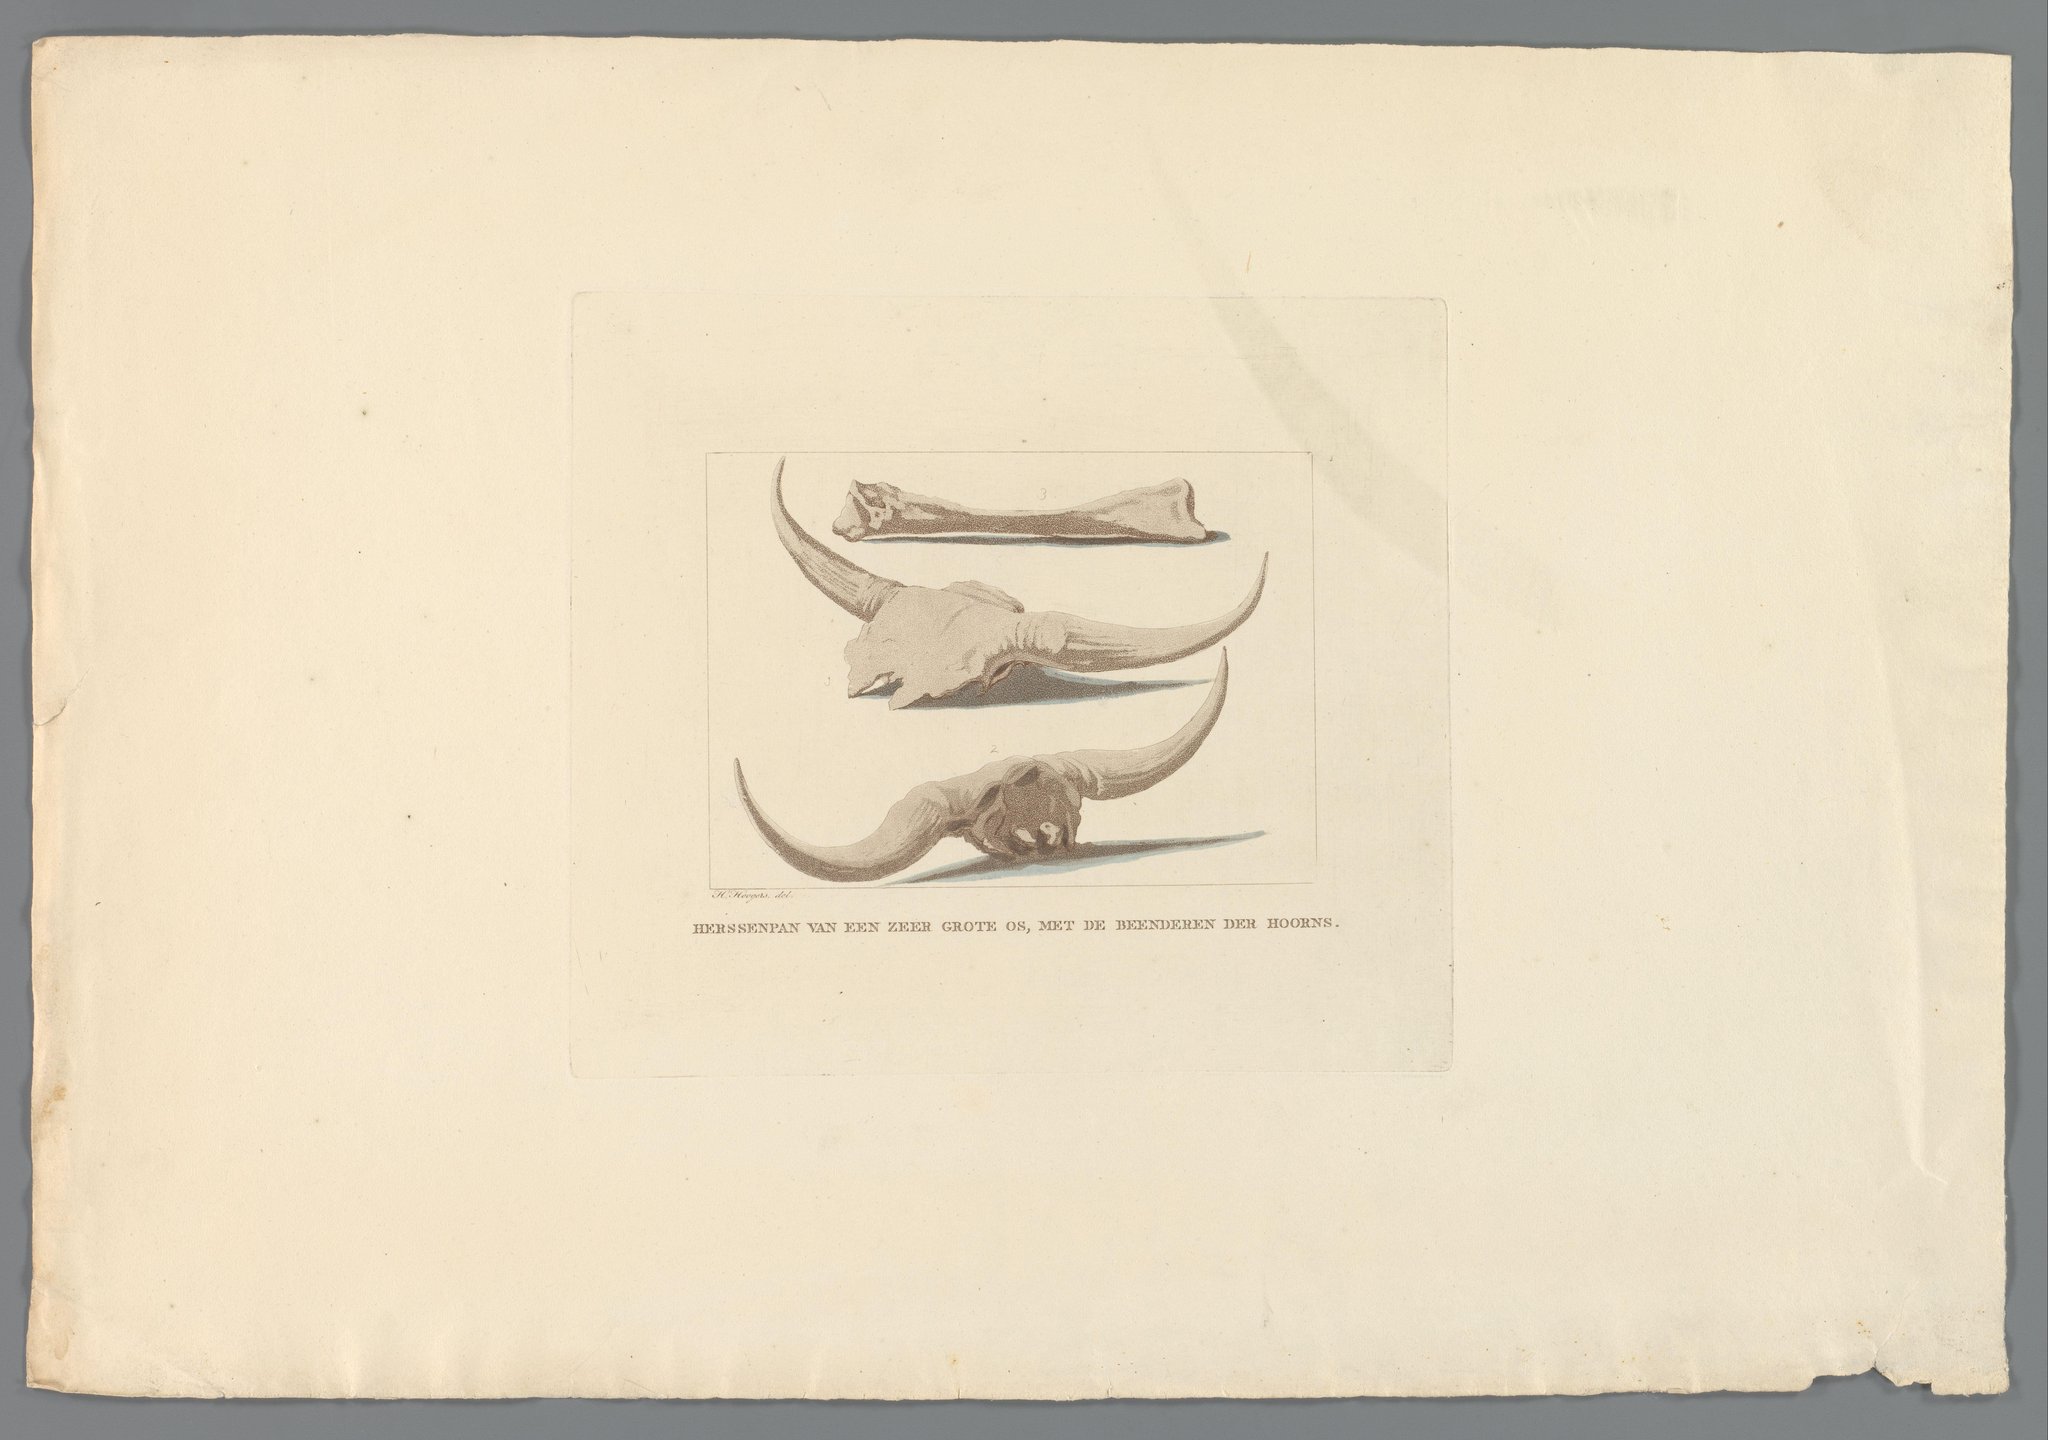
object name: print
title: Herssenpan van een zeer grote os, met de beenderen der hoorns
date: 1809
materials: paper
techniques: aquatint, etching, hand coloring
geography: amsterdam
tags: fossil animals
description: Prent ook gebruikt ter illustratie van: Ewijk, Hendrik. Geschiedkundig verslag der dijkbreuken en overstroomingen, langs de rivieren in het Koningrijk Holland, voorgevallen in louwmaand MDCCCIX. 3 dln. Amsterdam: Johannes Allart en Jacobus Ruys, 1809.